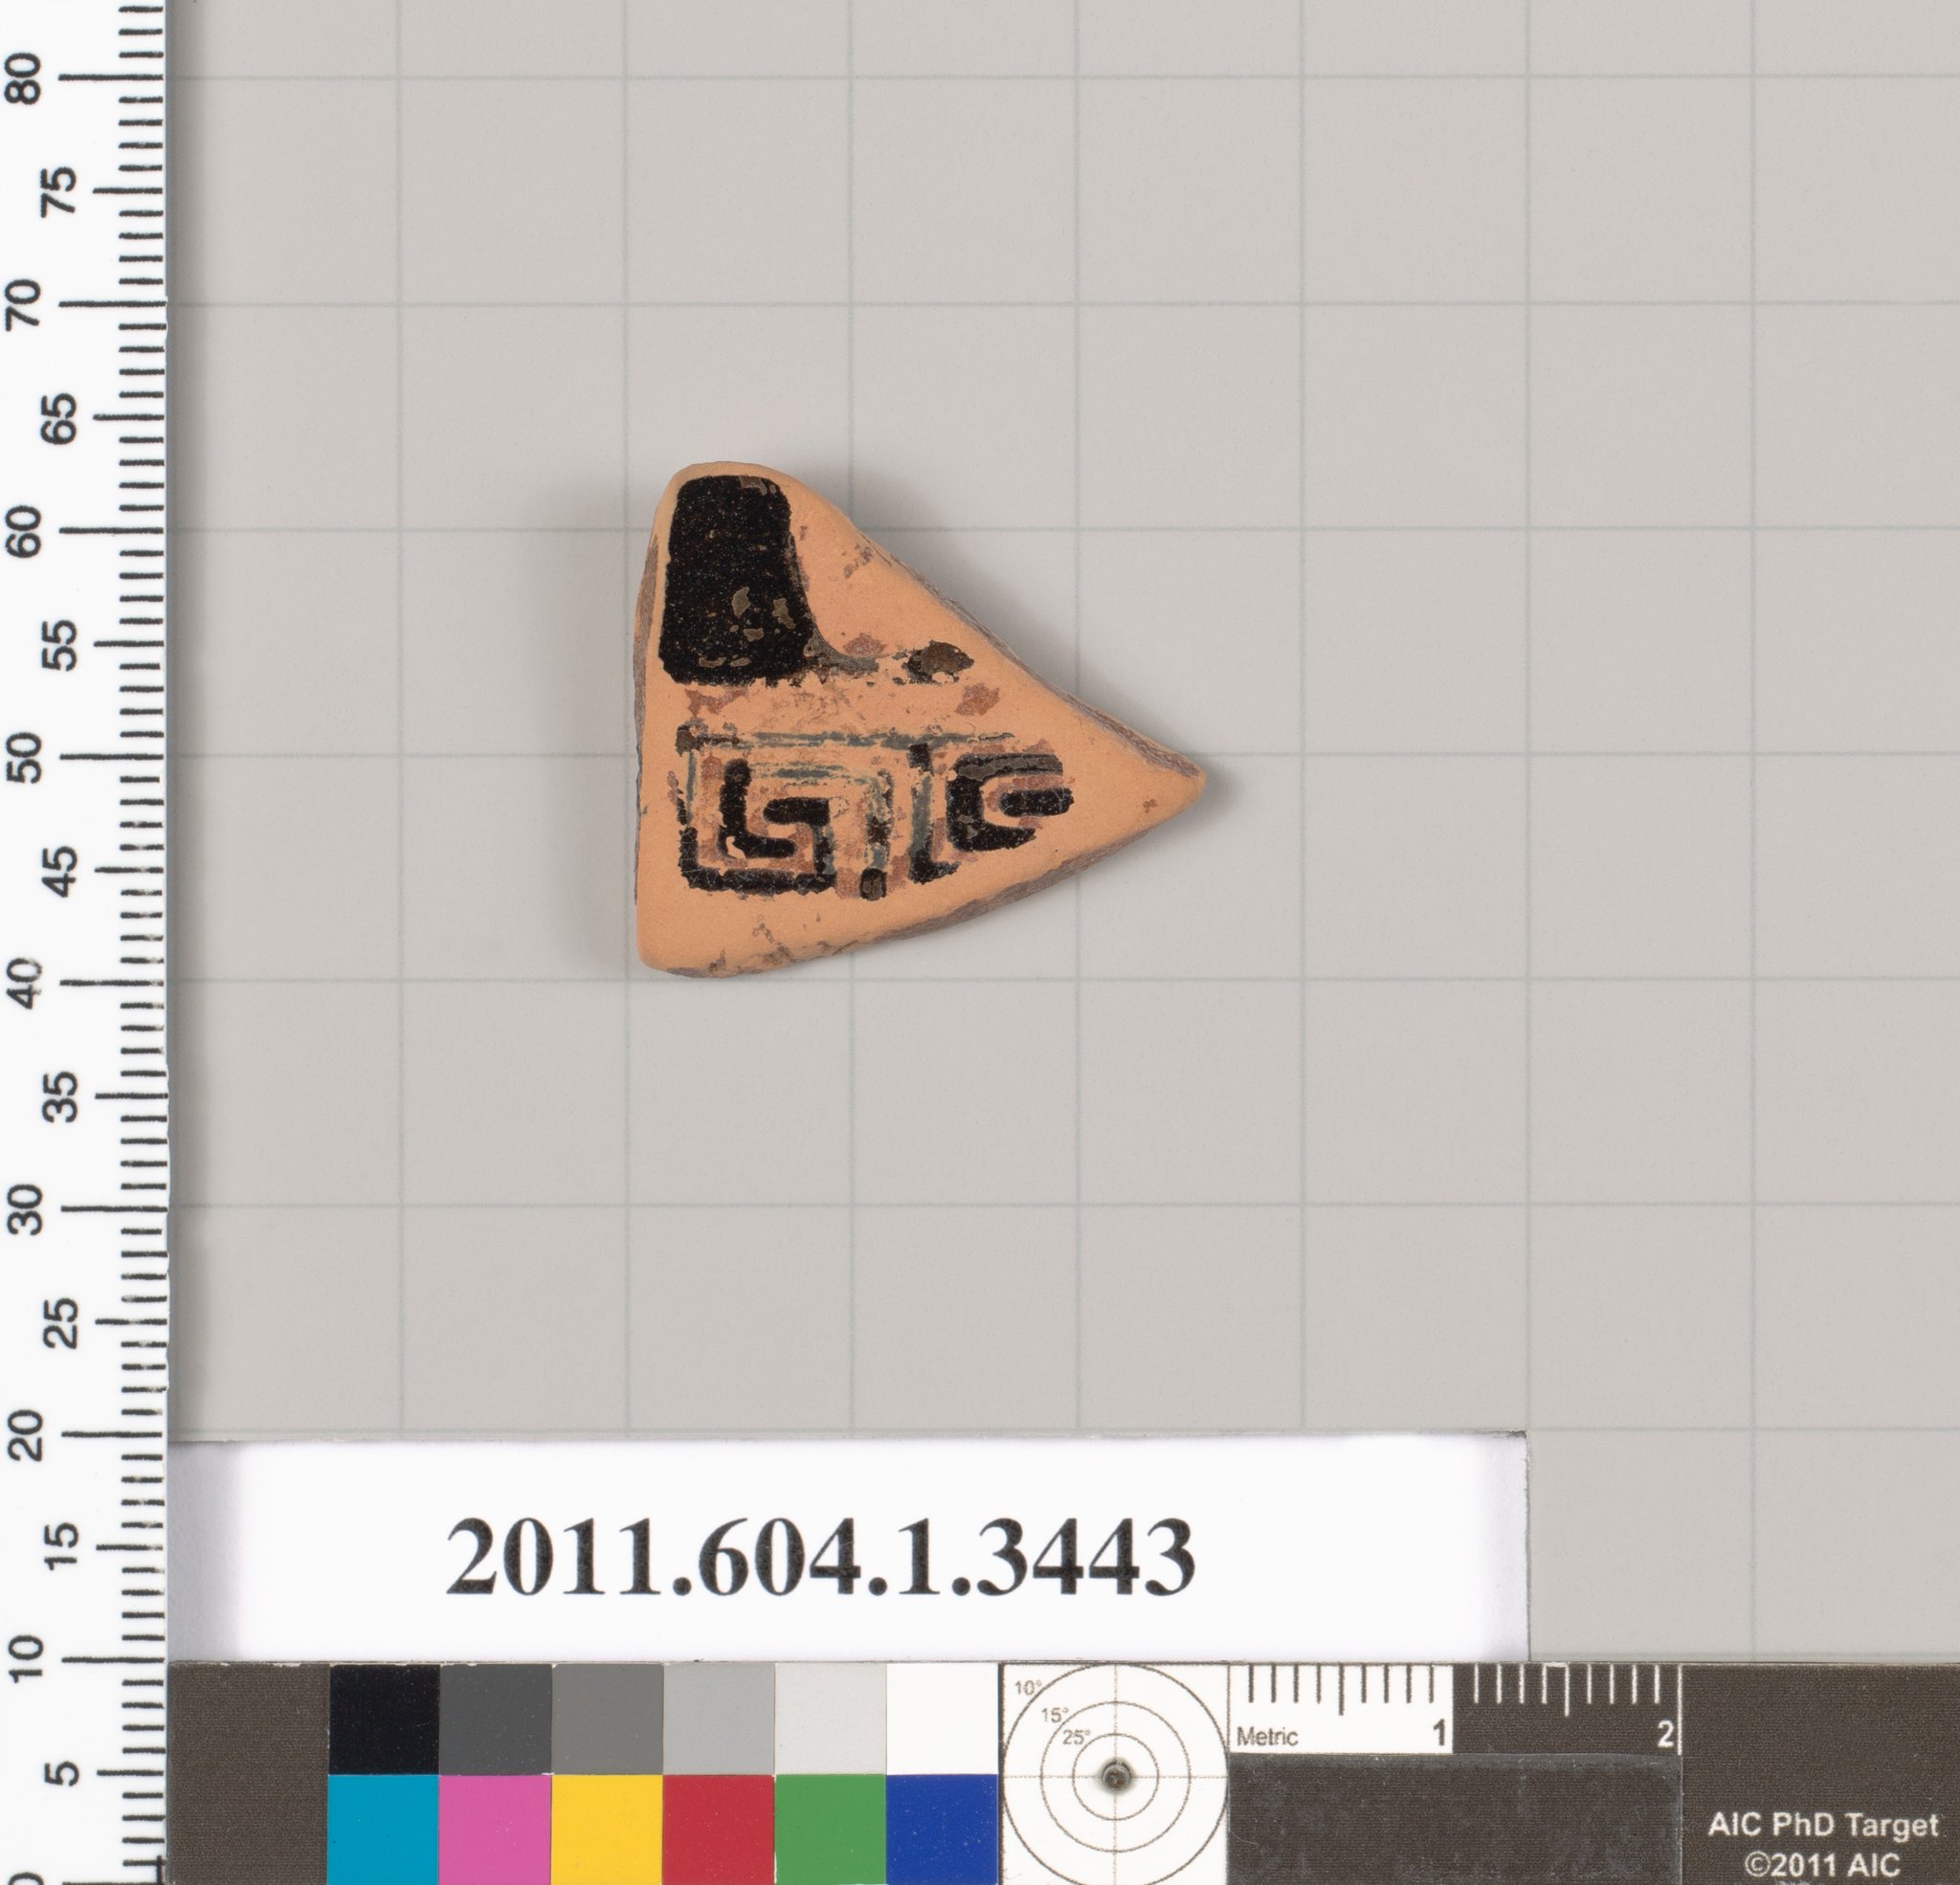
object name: kylix fragment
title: Terracotta fragment of a kylix (drinking cup)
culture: greek, attic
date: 490-470 BCE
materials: terracotta